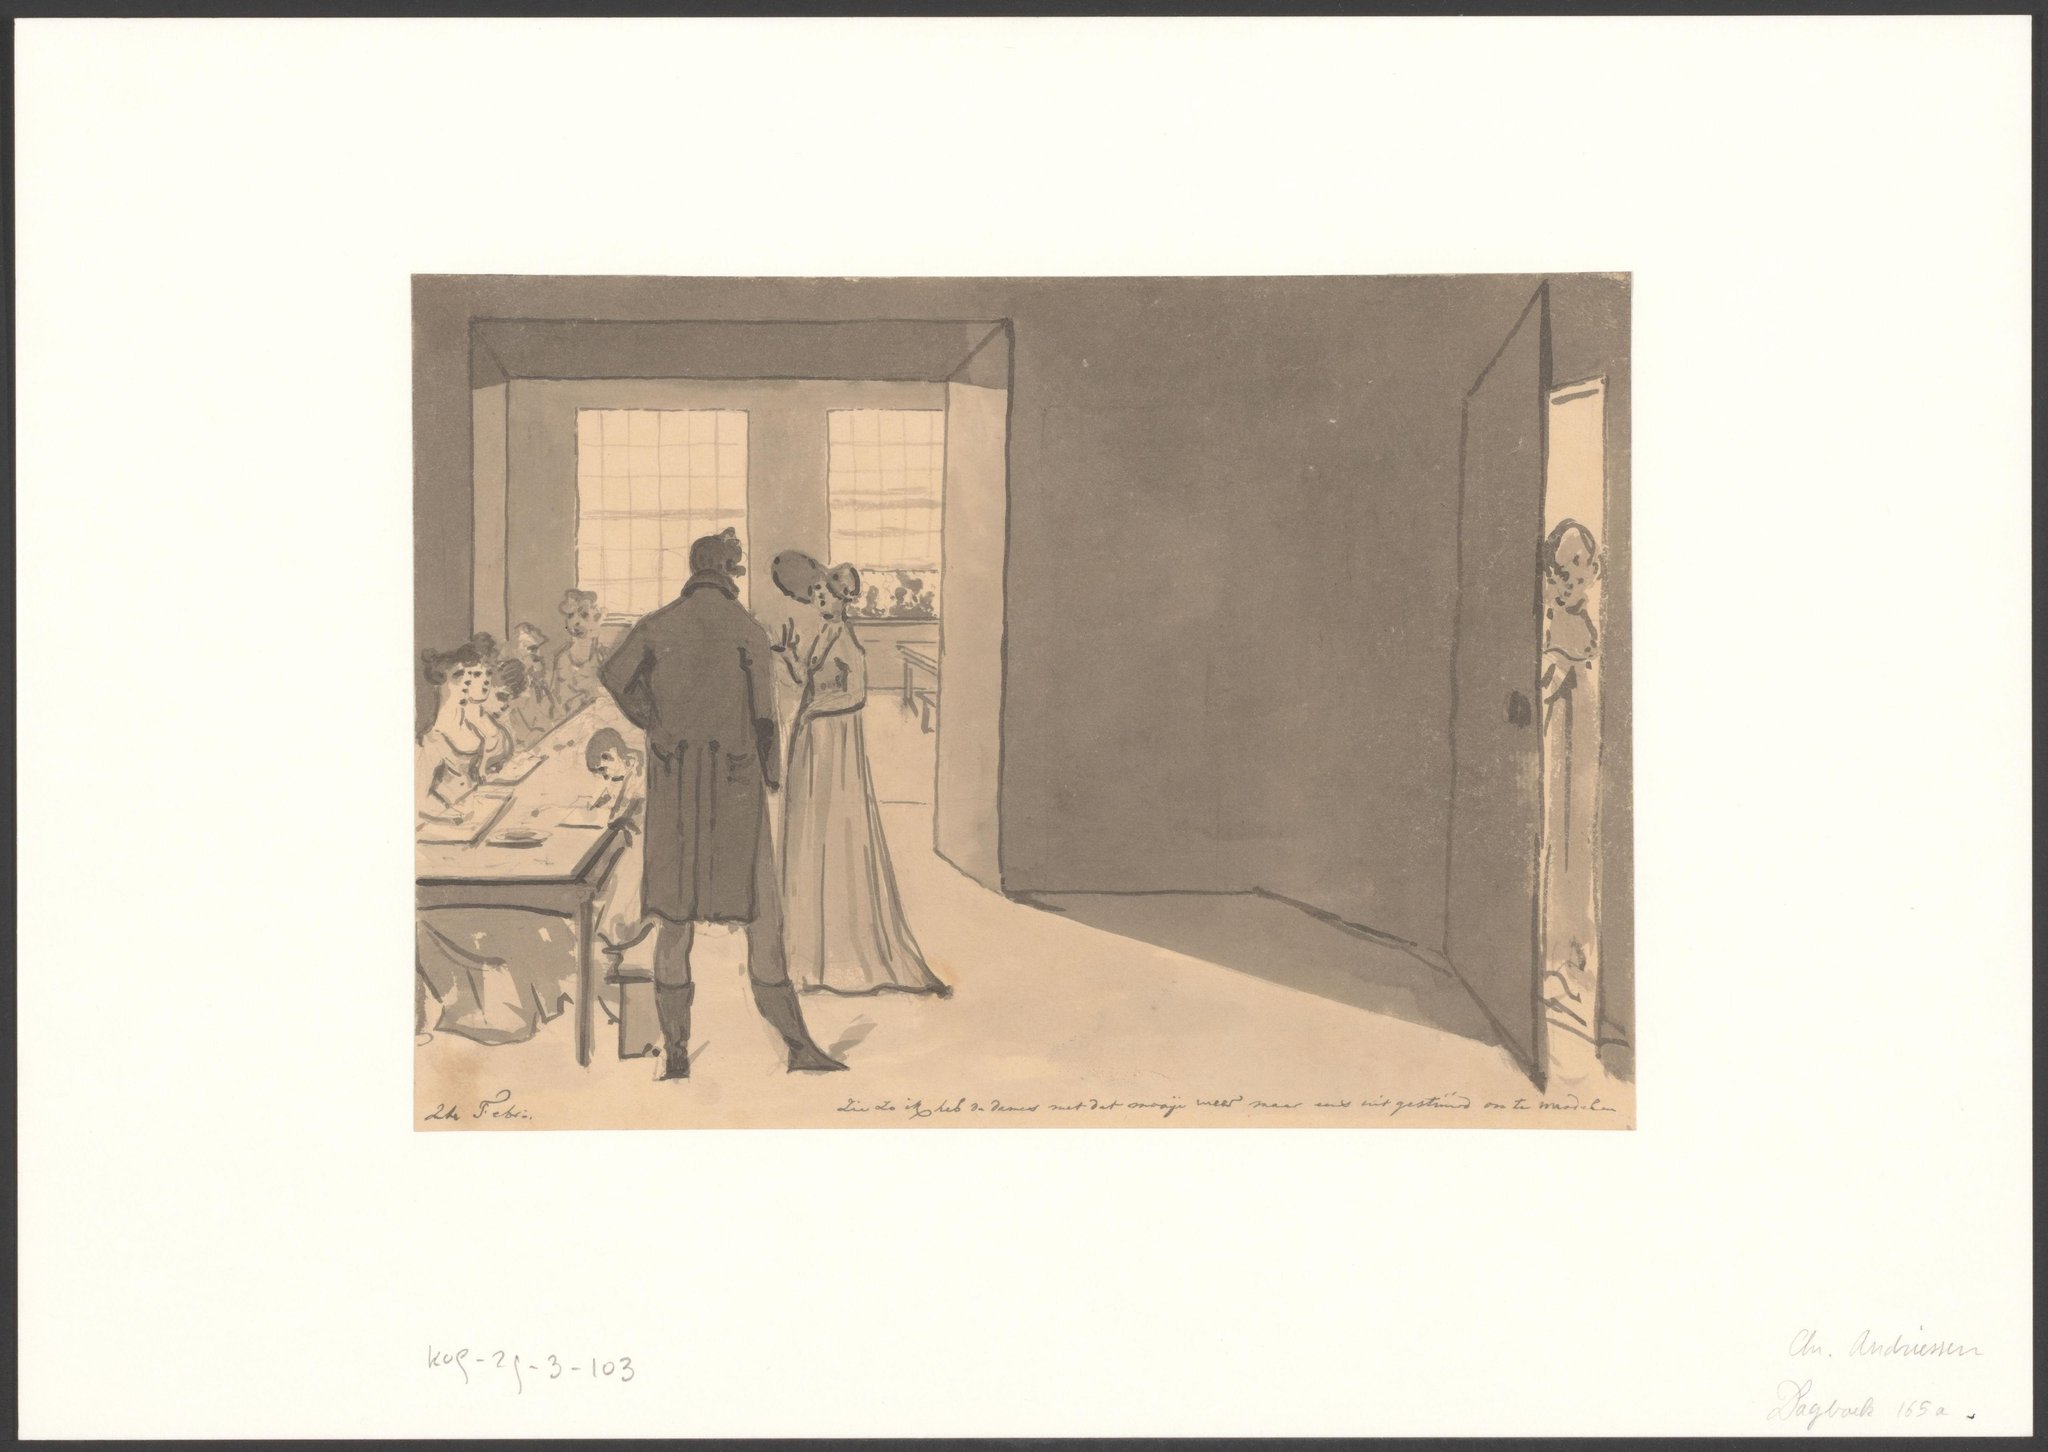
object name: drawing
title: Christiaan Andriessen heeft een gesprek met juffrouw Zeydelaar op de meisjeskostschool te Weesp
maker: christiaan andriessen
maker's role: draughtsman, print maker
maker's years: 1775-1846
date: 1806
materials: ink, paper, pencil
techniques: brush, pen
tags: elementary school; class, form (+ teacher, professor), elementary school; class, form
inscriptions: inscription: ‘24 Febr Zie zo ik heb de dames met dat mooije weer maar eens uit gestuurd om te wandelen’, signature: ‘J Andriessen’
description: Dagboekblad uit het getekende dagboek dat Christiaan Andriessen bijhield van 1805 tot en met 1808.